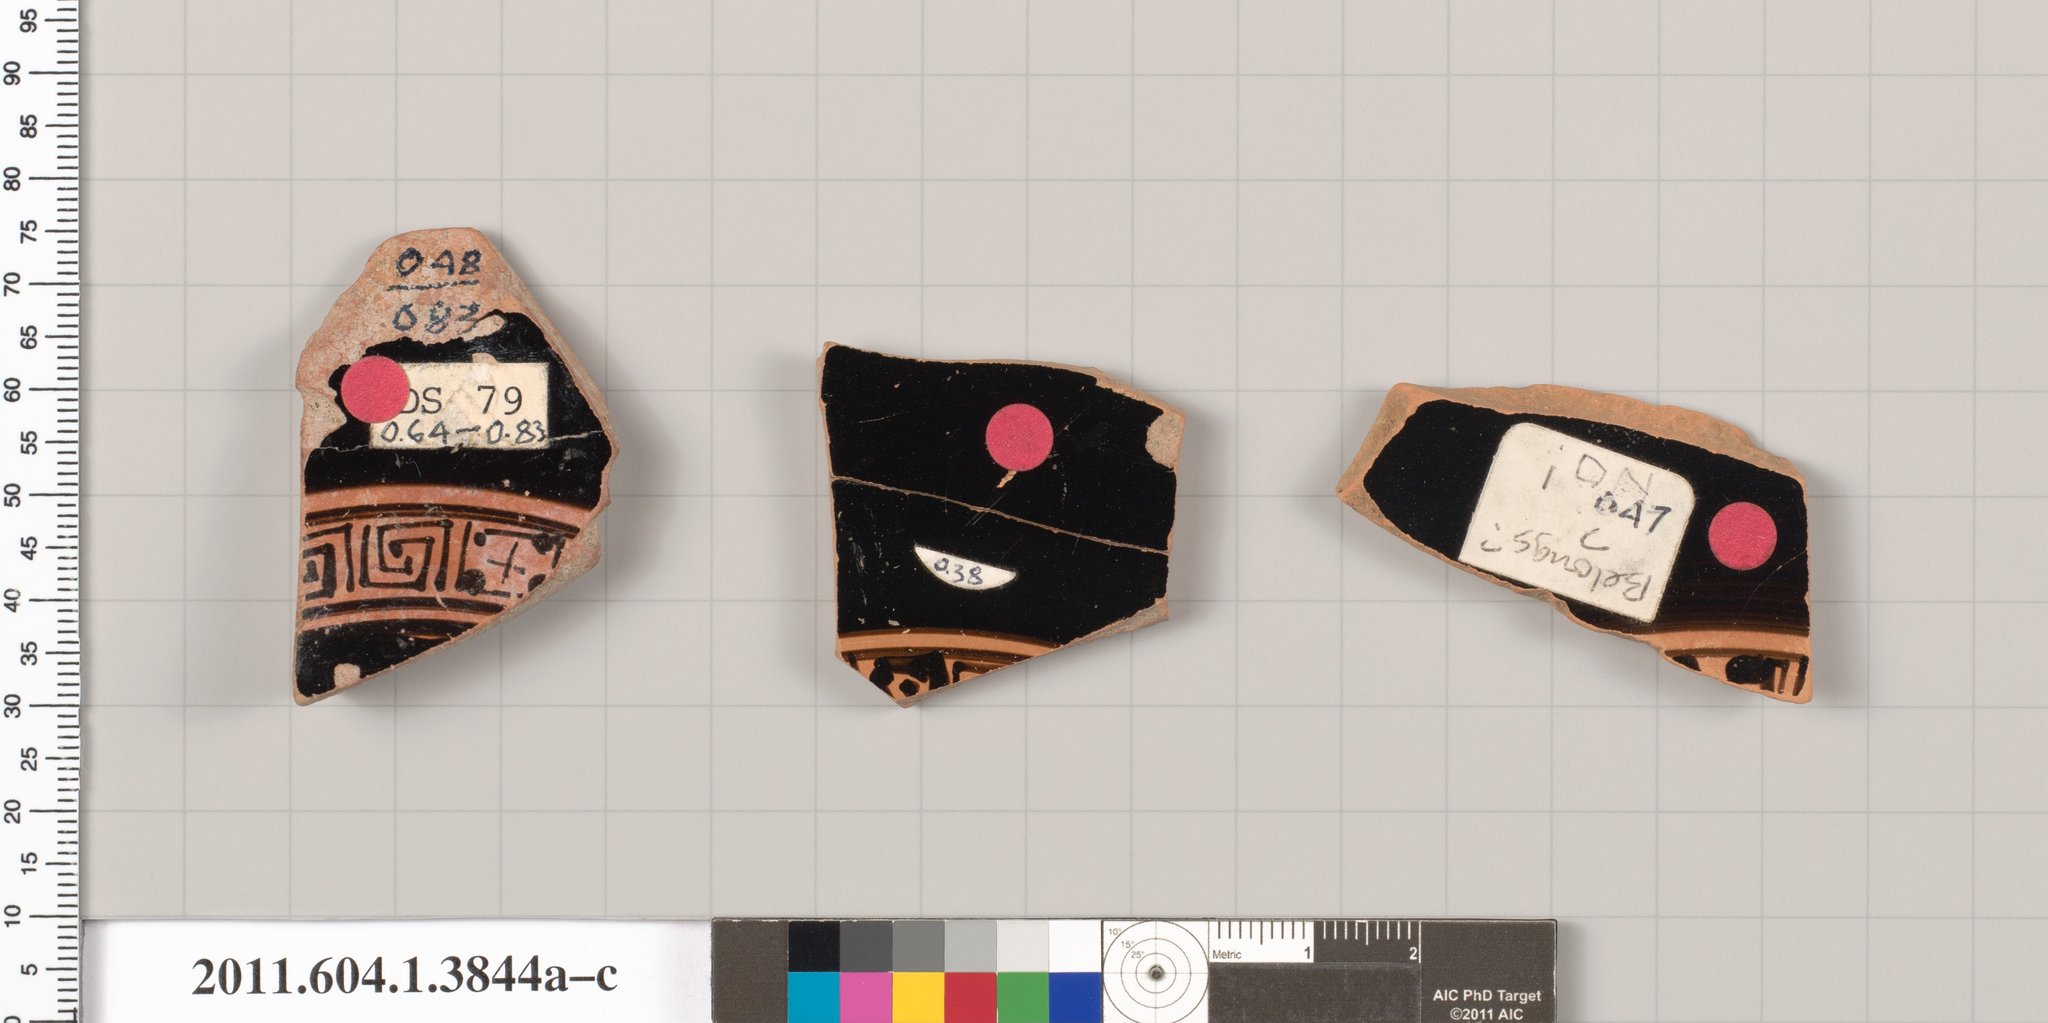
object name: kylix fragment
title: Terracotta fragments of kylikes (drinking cups)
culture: greek, attic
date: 460-440 BCE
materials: terracotta